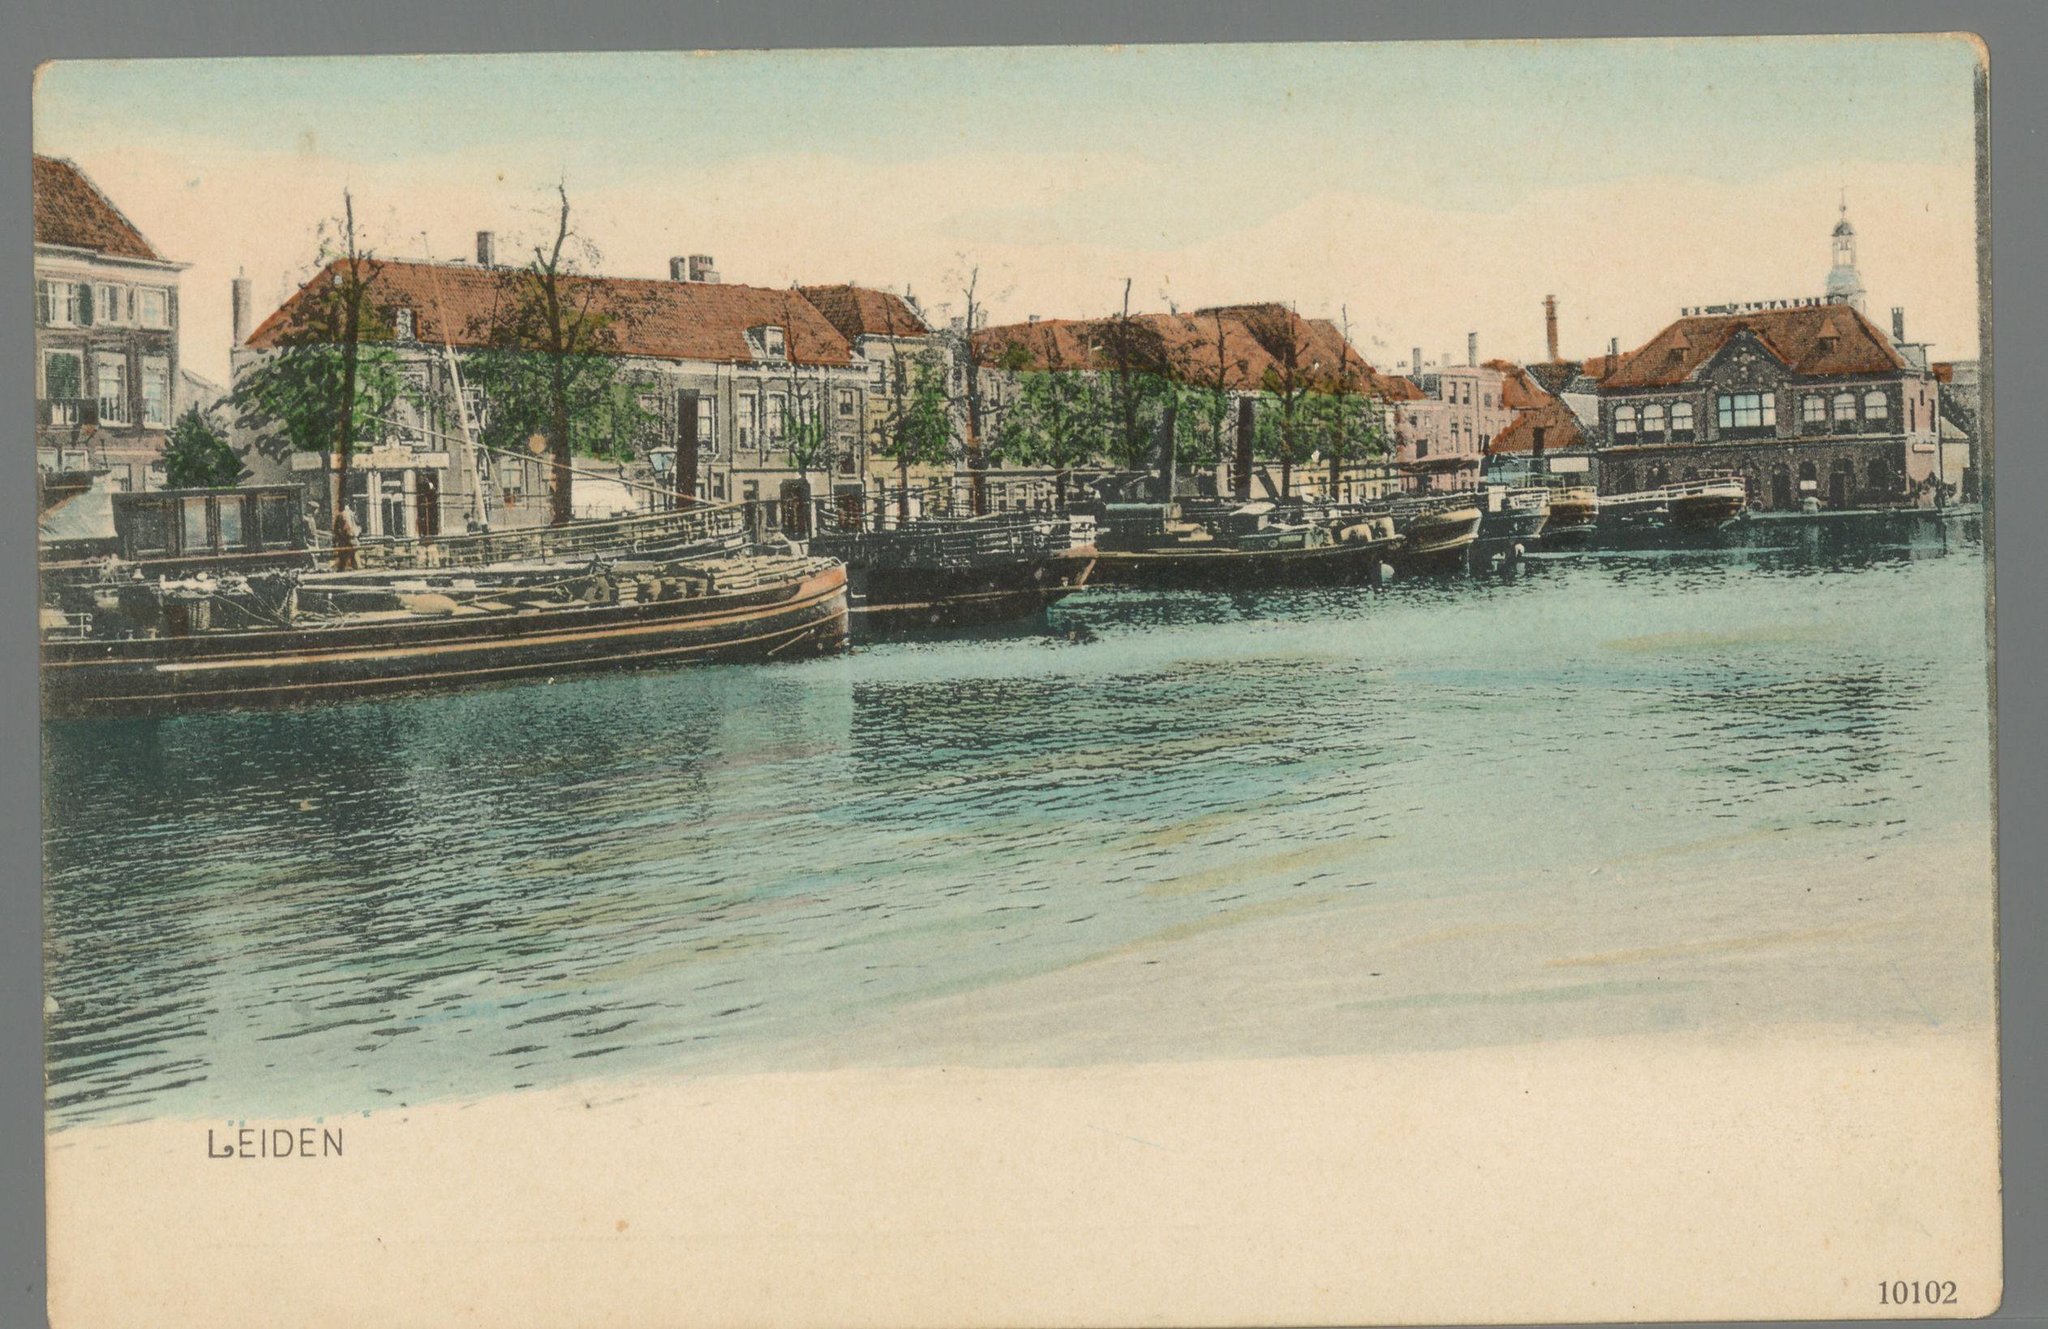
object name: ansichtkaart, prentbriefkaart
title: Leiden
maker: Anonymous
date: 1897-1905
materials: cardboard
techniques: photograph, lithograph, hand coloring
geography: leiden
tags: canal, street, leiden